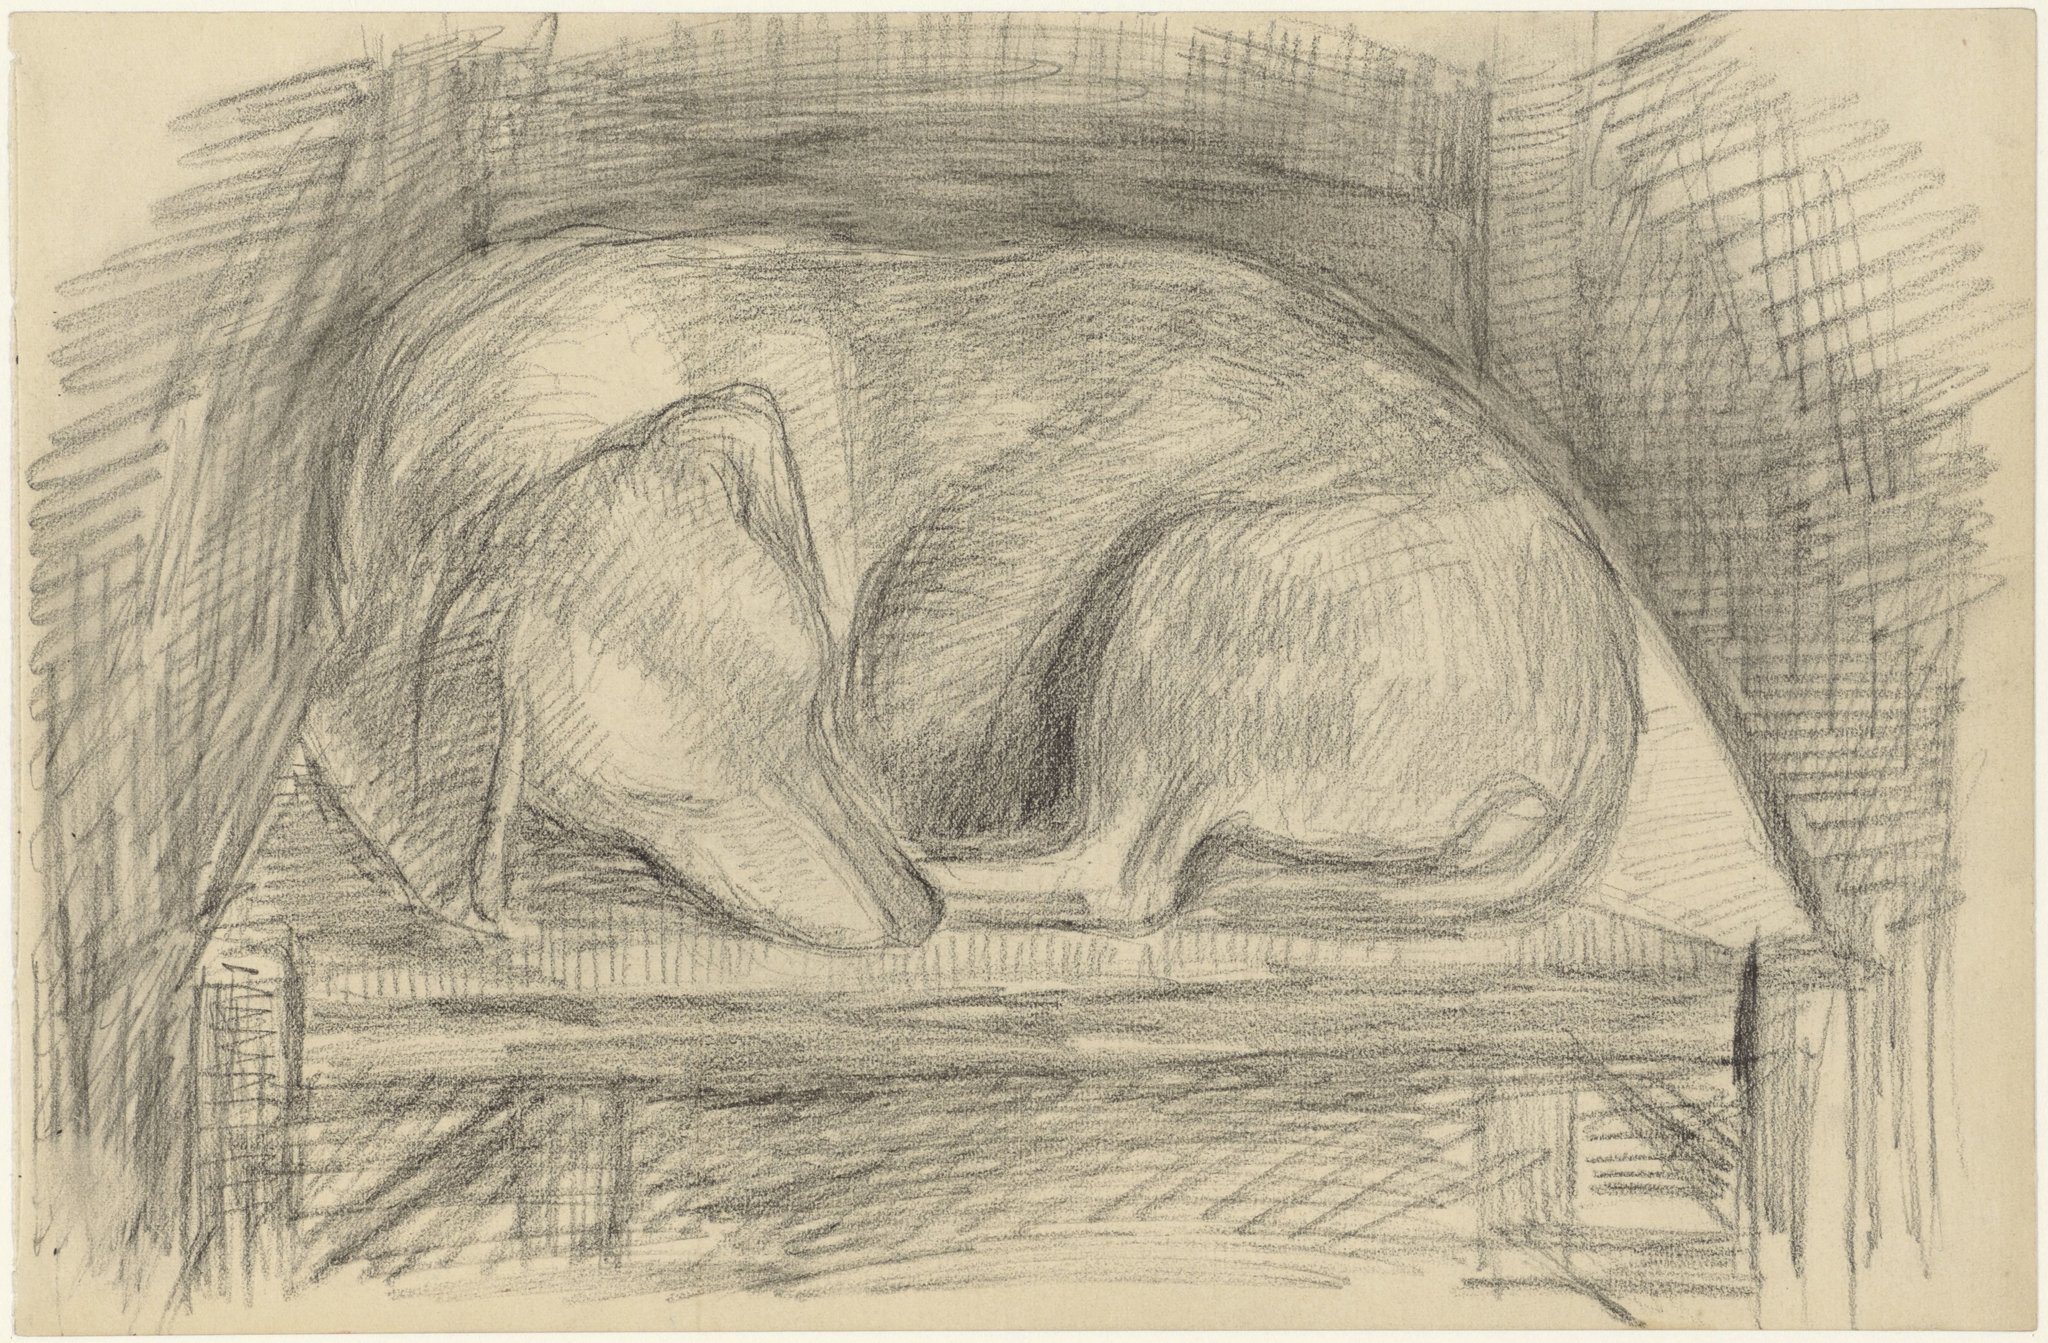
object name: drawing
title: Slapende hond op een stoel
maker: jozef israëls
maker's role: draughtsman, painter, print maker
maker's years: 1824-1911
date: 1834-1911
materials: chalk, paper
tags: dog